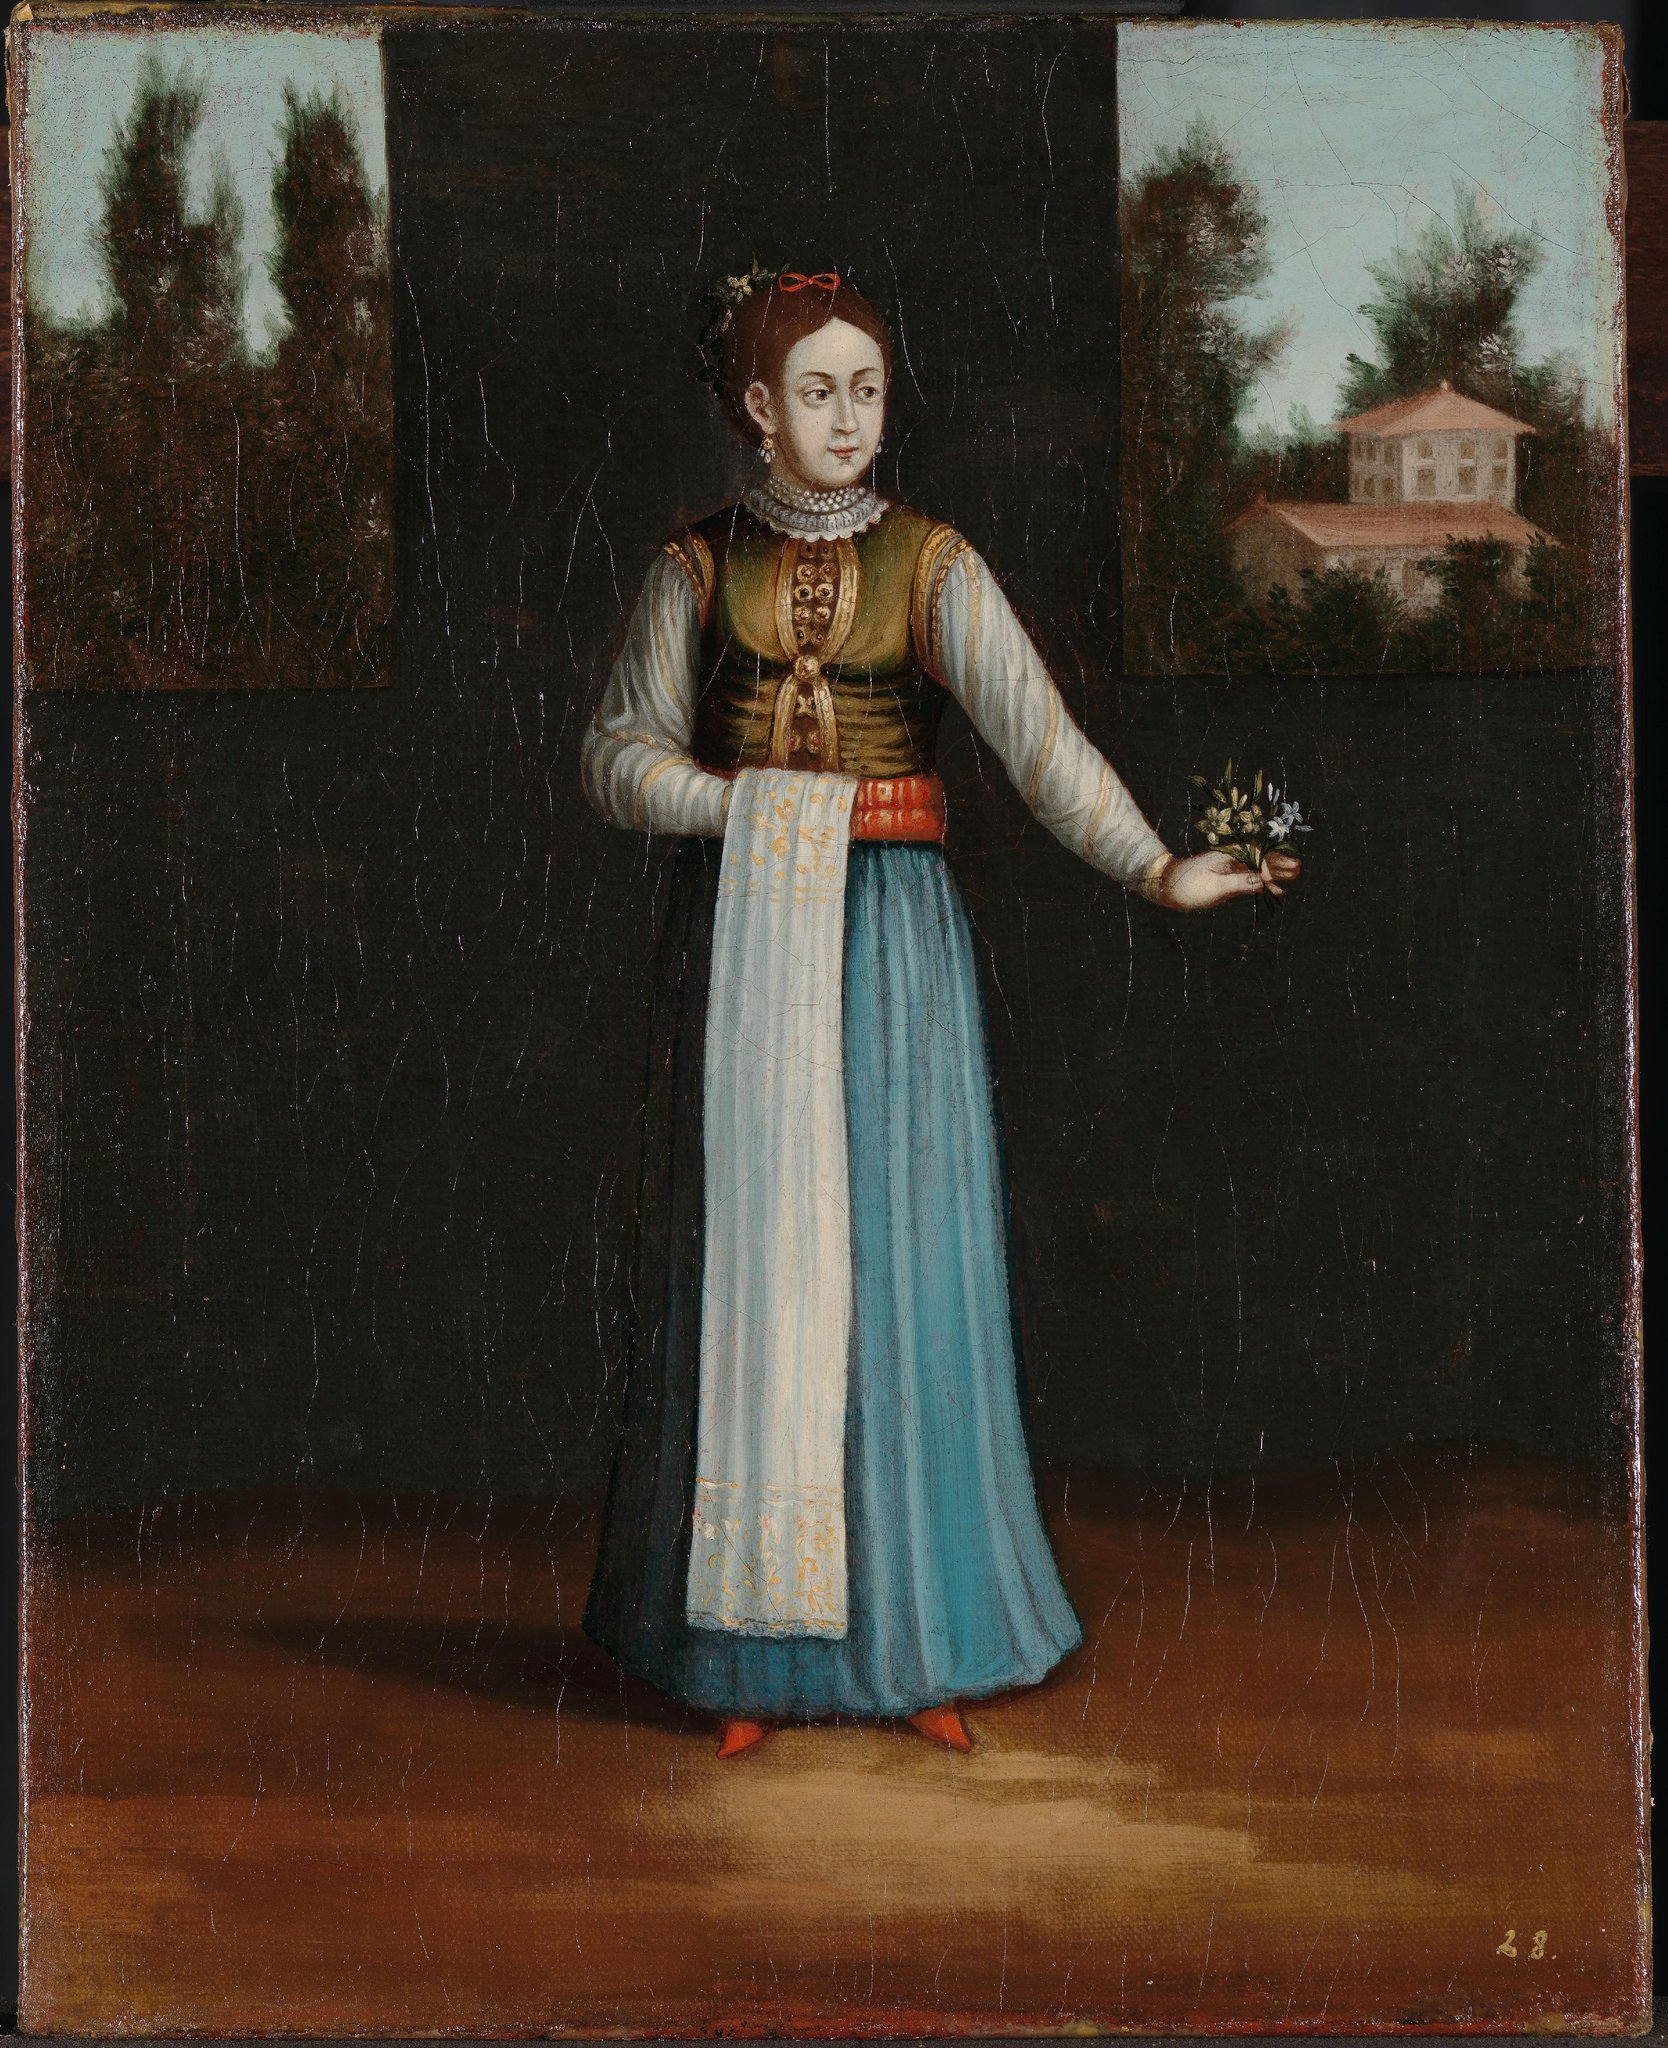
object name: painting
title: Woman from the Albanian Coast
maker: jean baptiste vanmour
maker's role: painter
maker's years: 1671-1737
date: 1700-1737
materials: canvas, oil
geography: istanbul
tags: folk costume, regional costume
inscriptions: inscription: ‘Een vrouw van de kust Arbano/ Vanmour’, number: ‘28’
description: Een vrouw van de Albanese kust. Staande, ten voeten uit, in de uitgestoken linkerhand houdt zij een bosje bloemen. Rechts op de achtergrond een huis.